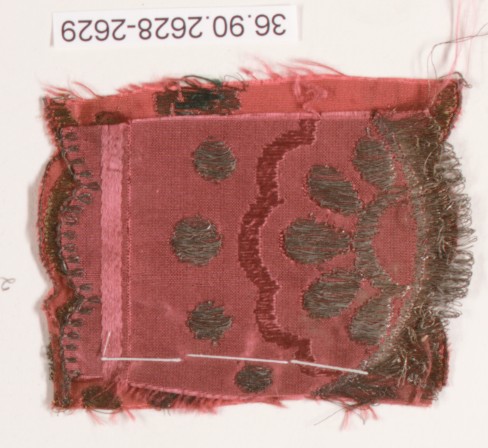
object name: ribbon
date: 1801-1900